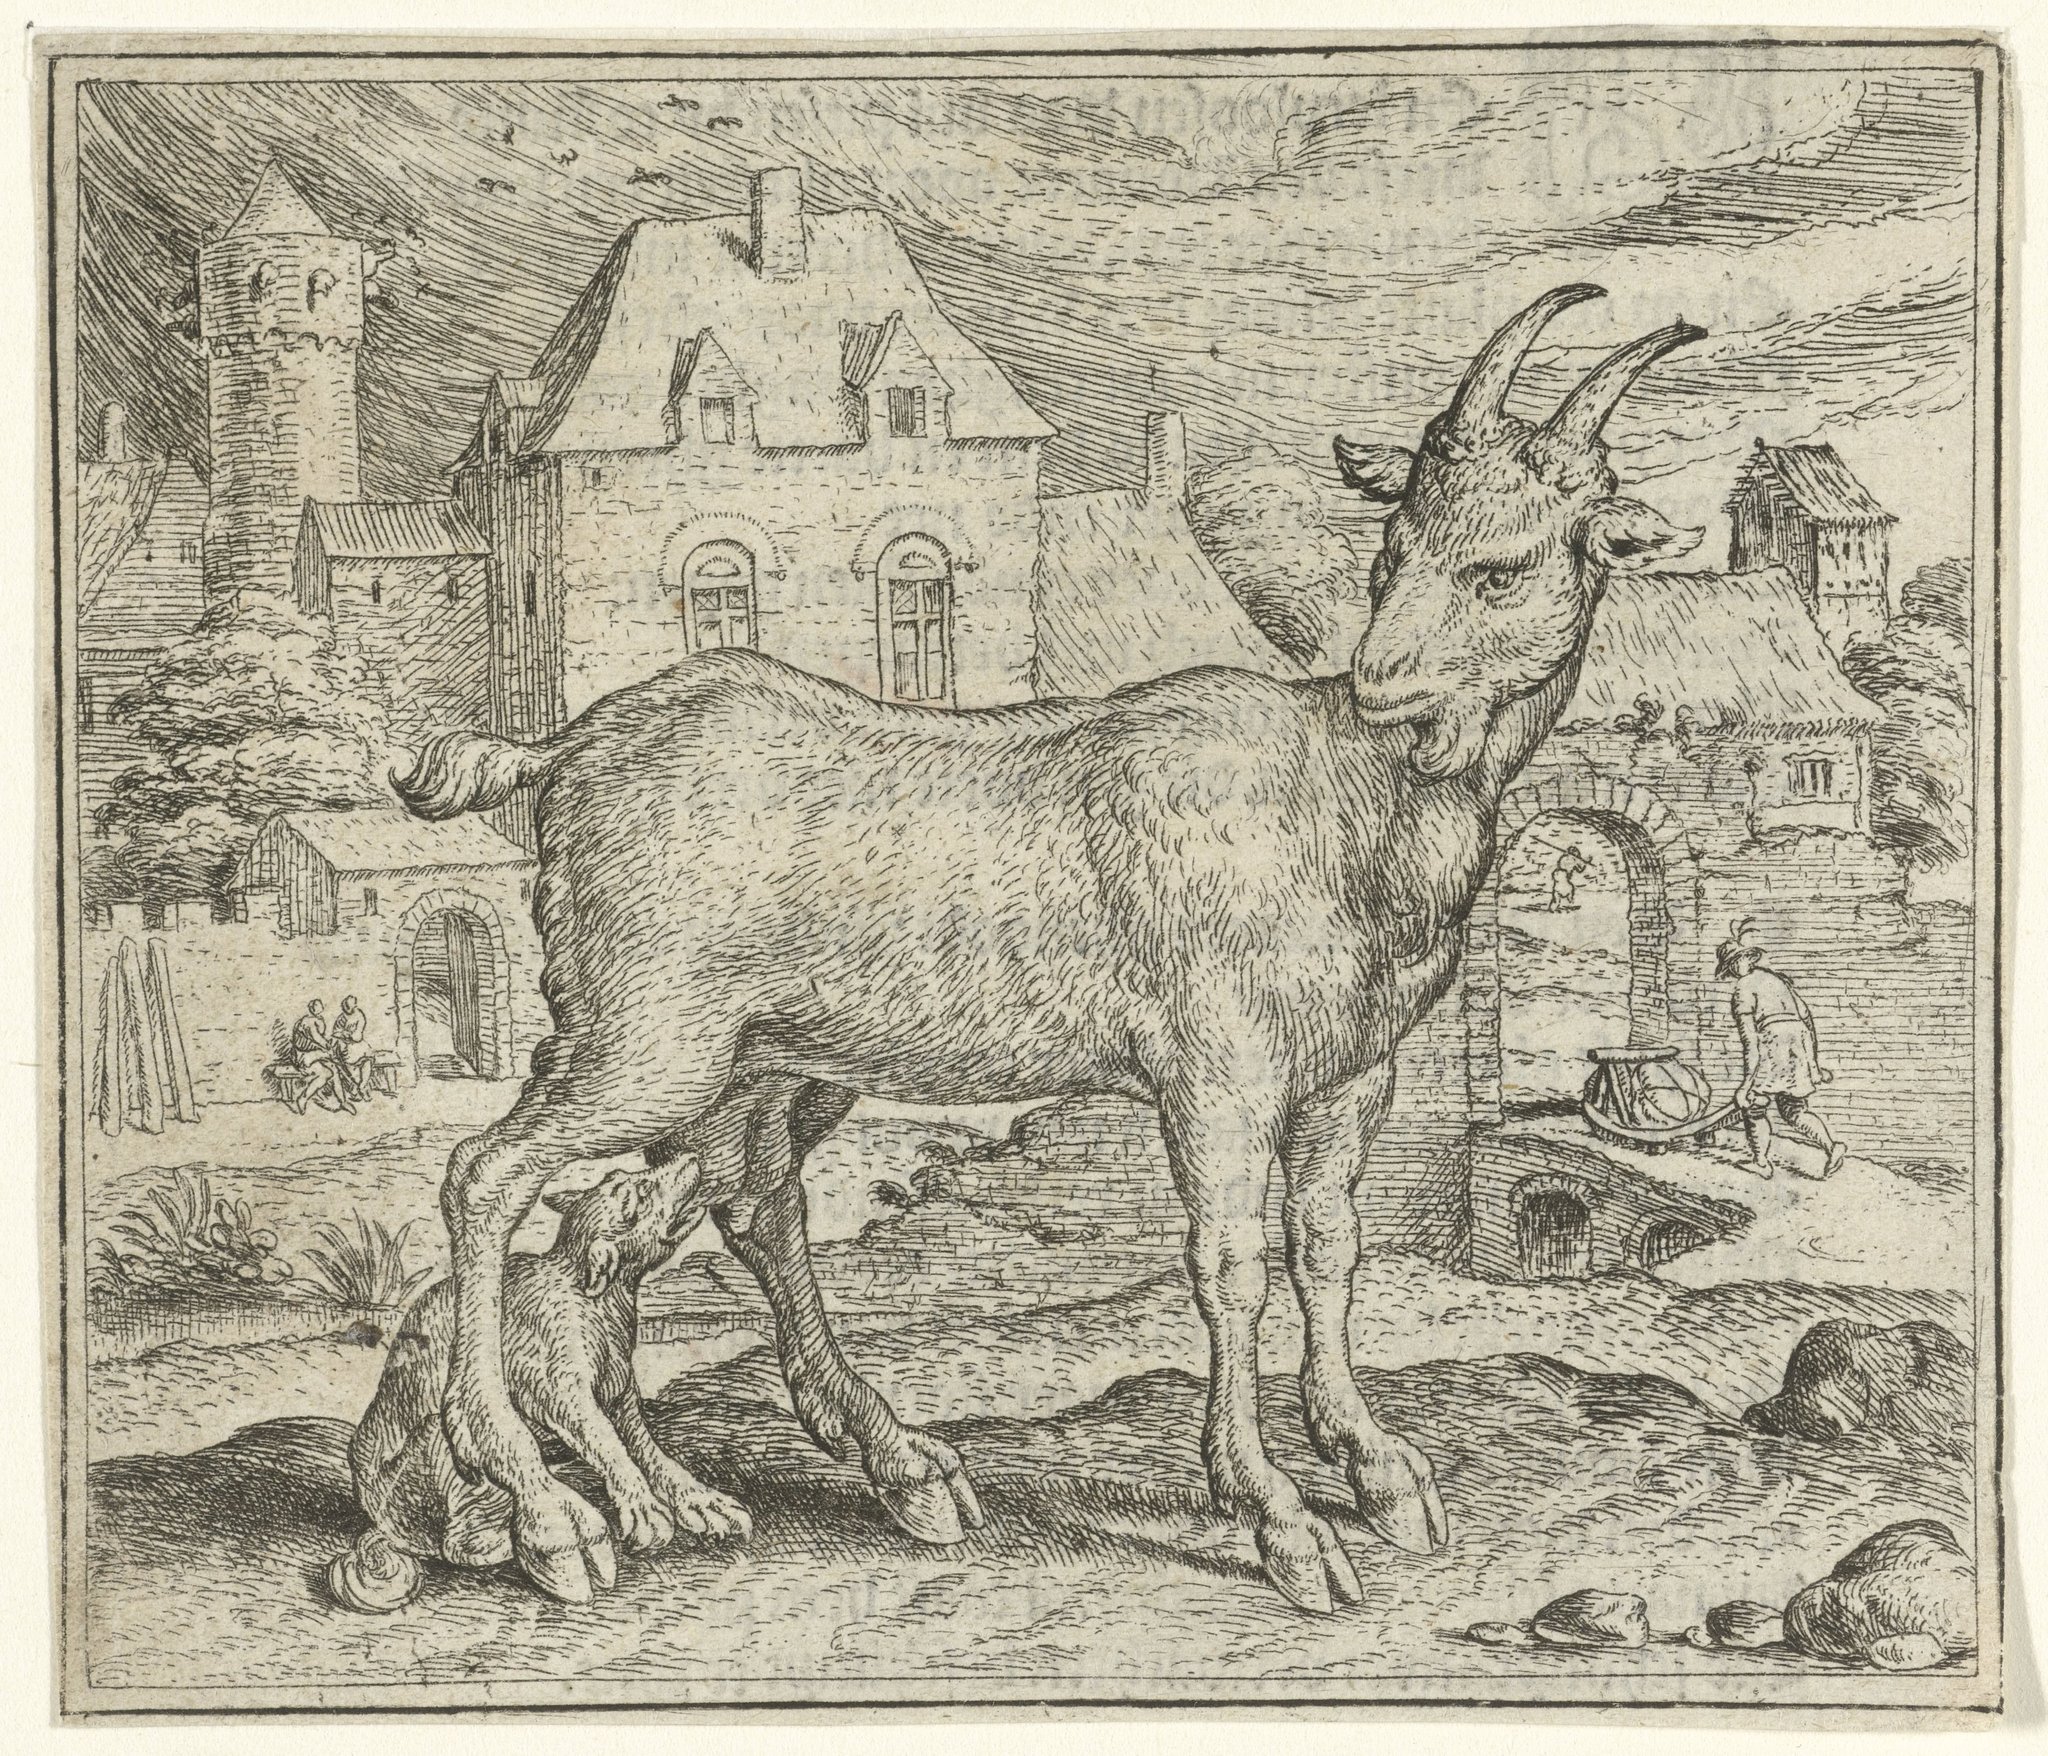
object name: book illustration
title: Fabel van de geit en de jonge wolf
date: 1567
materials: paper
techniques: etching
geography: bruges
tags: she-goat, nanny-goat, fables of aesop (with title) : use 85(...), beasts of prey, predatory animals: wolf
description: Een geit laat toe dat een jonge wolf zich voedt met de melk uit haar uier. Barmhartigheid overstijgt zelfs de grootste vijanden.